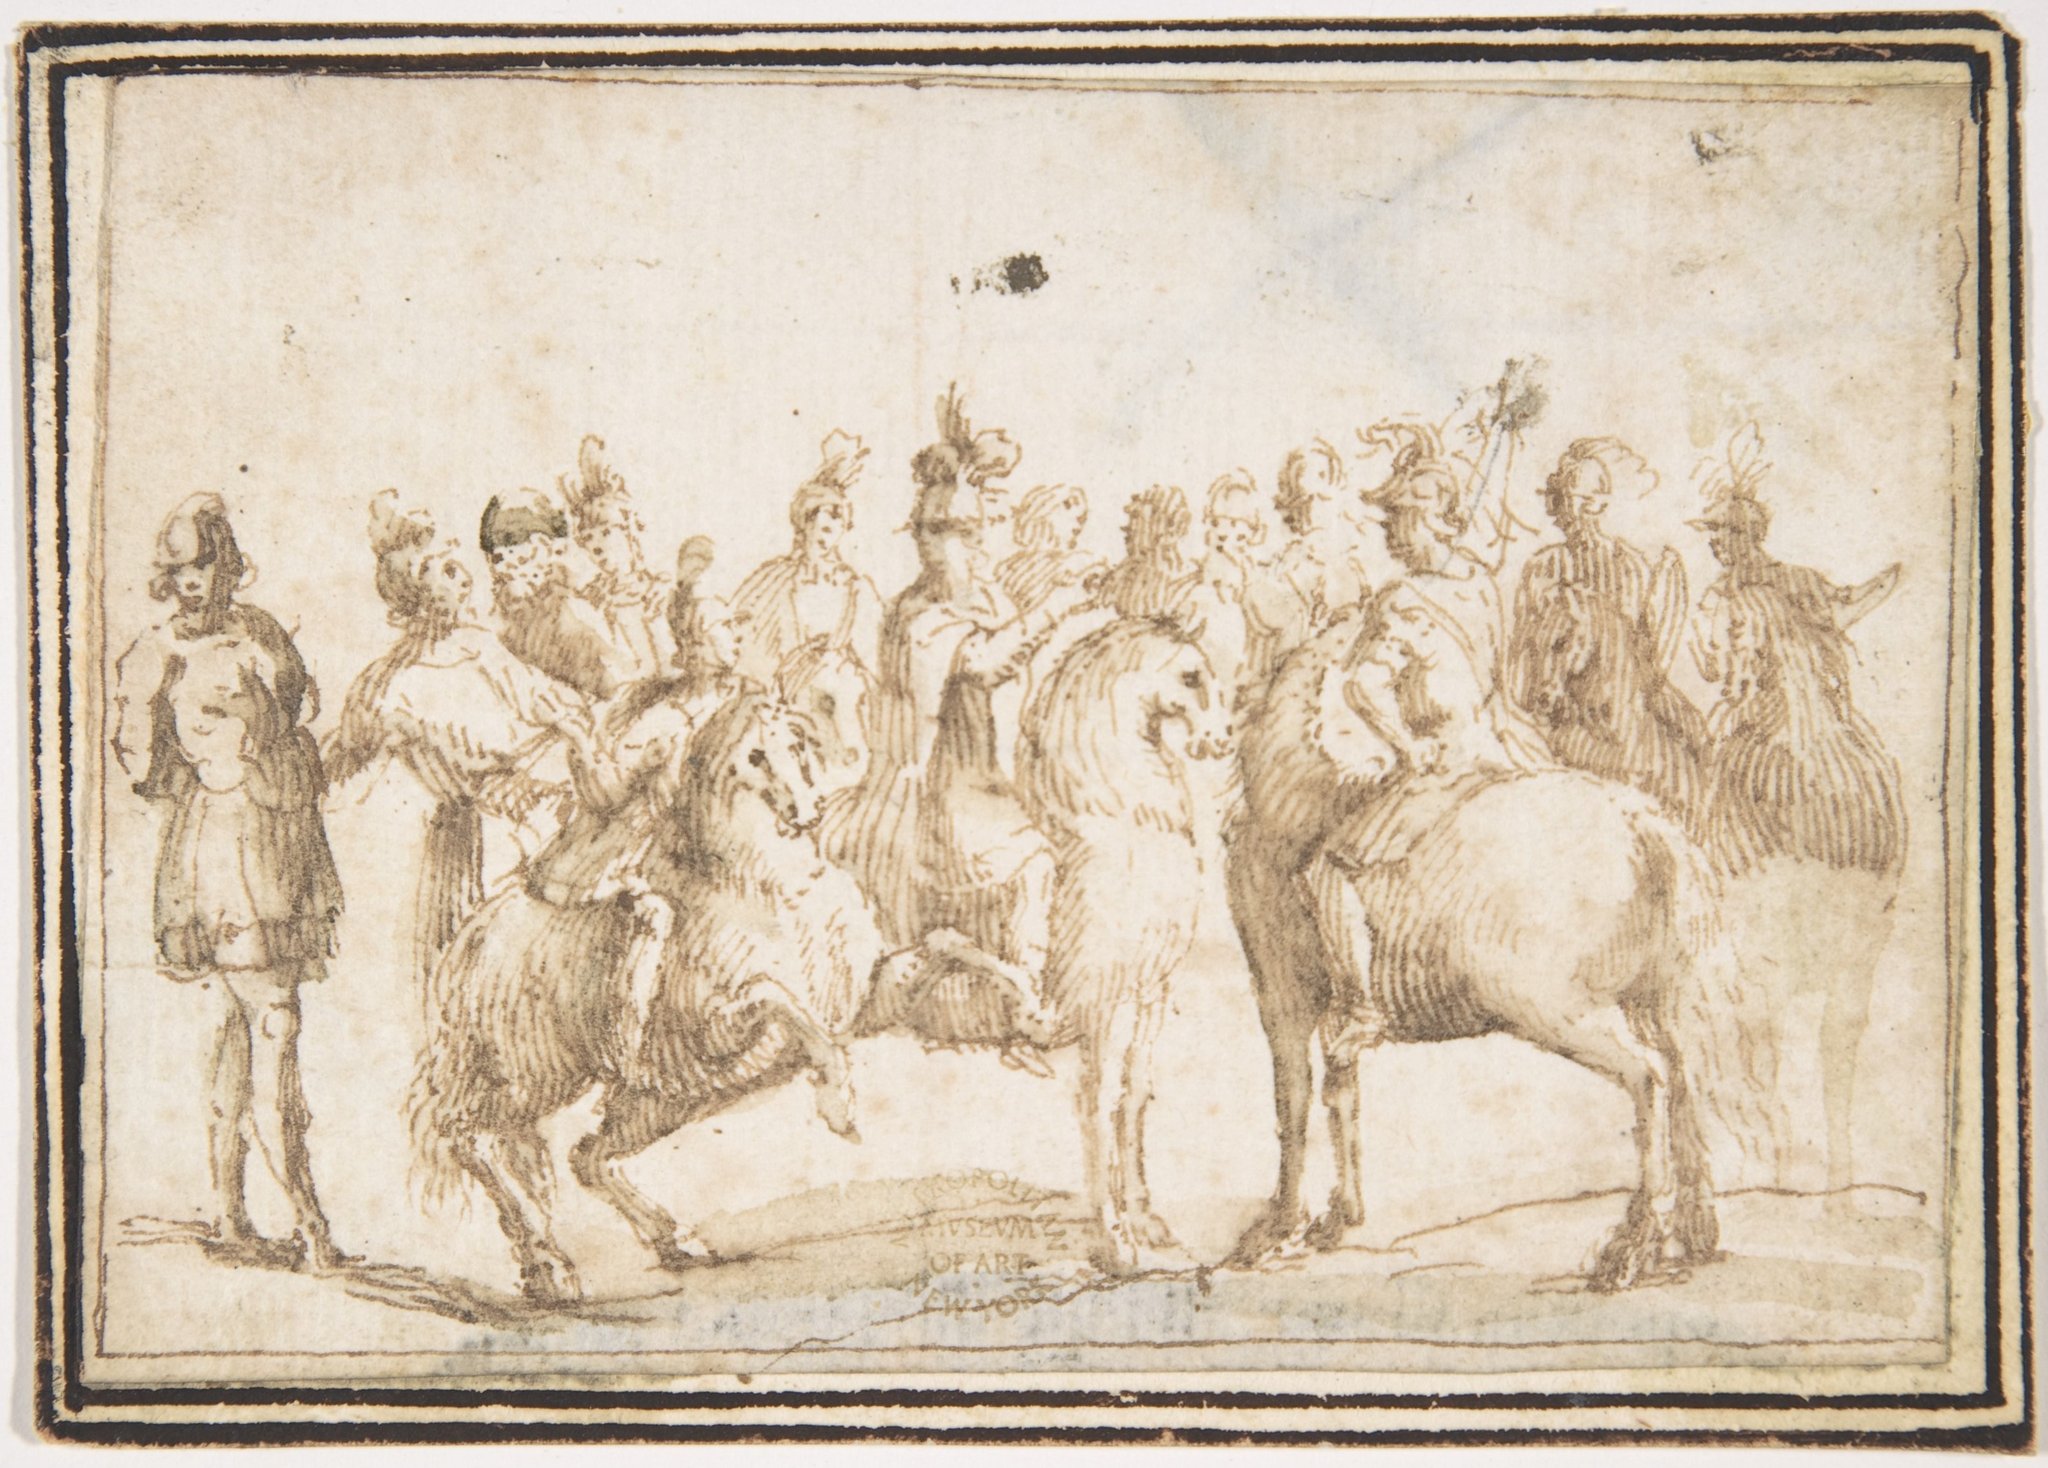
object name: drawing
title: Group of Horsemen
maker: francesco allegrini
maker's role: artist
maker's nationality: italian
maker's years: 1615-1679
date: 1624-1663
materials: ink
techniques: pen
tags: men,horses